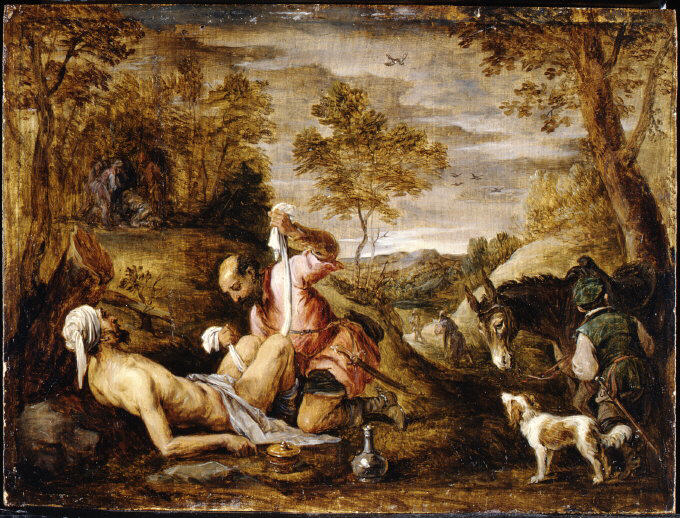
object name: painting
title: The Good Samaritan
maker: david teniers the younger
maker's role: artist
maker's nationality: flemish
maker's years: 1610-1690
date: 1630-1690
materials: oil, wood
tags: illness,men,dogs,donkeys,landscapes